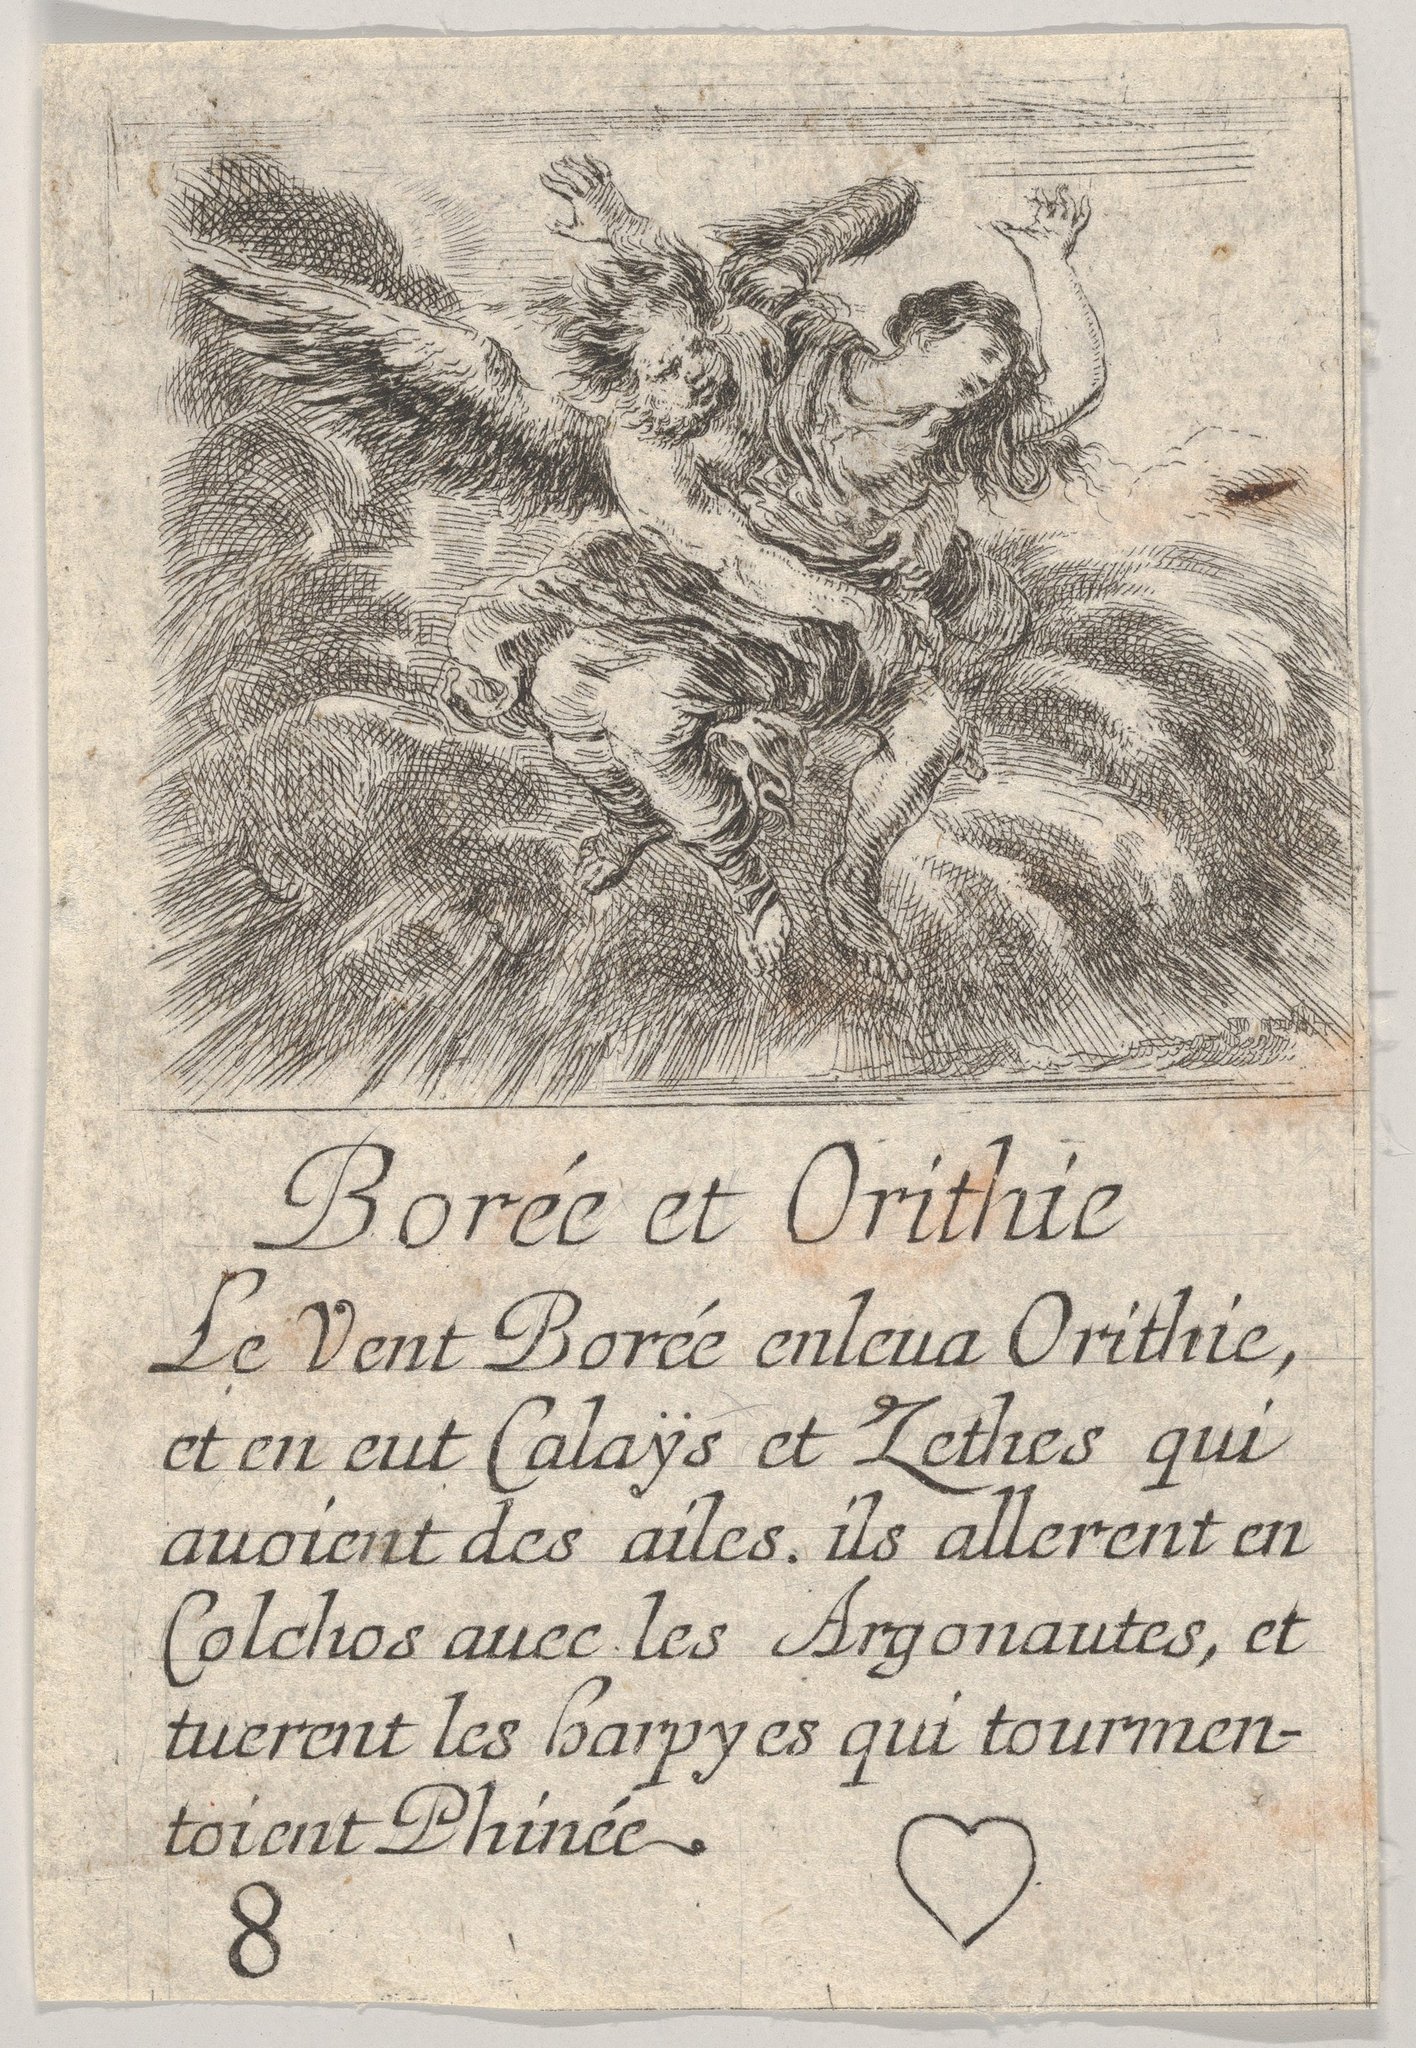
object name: print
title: Boreas and Orithyia, from "Game of Mythology" (Jeu de la Mythologie)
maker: stefano della bella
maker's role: artist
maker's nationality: italian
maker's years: 1610-1664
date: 1644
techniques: etching